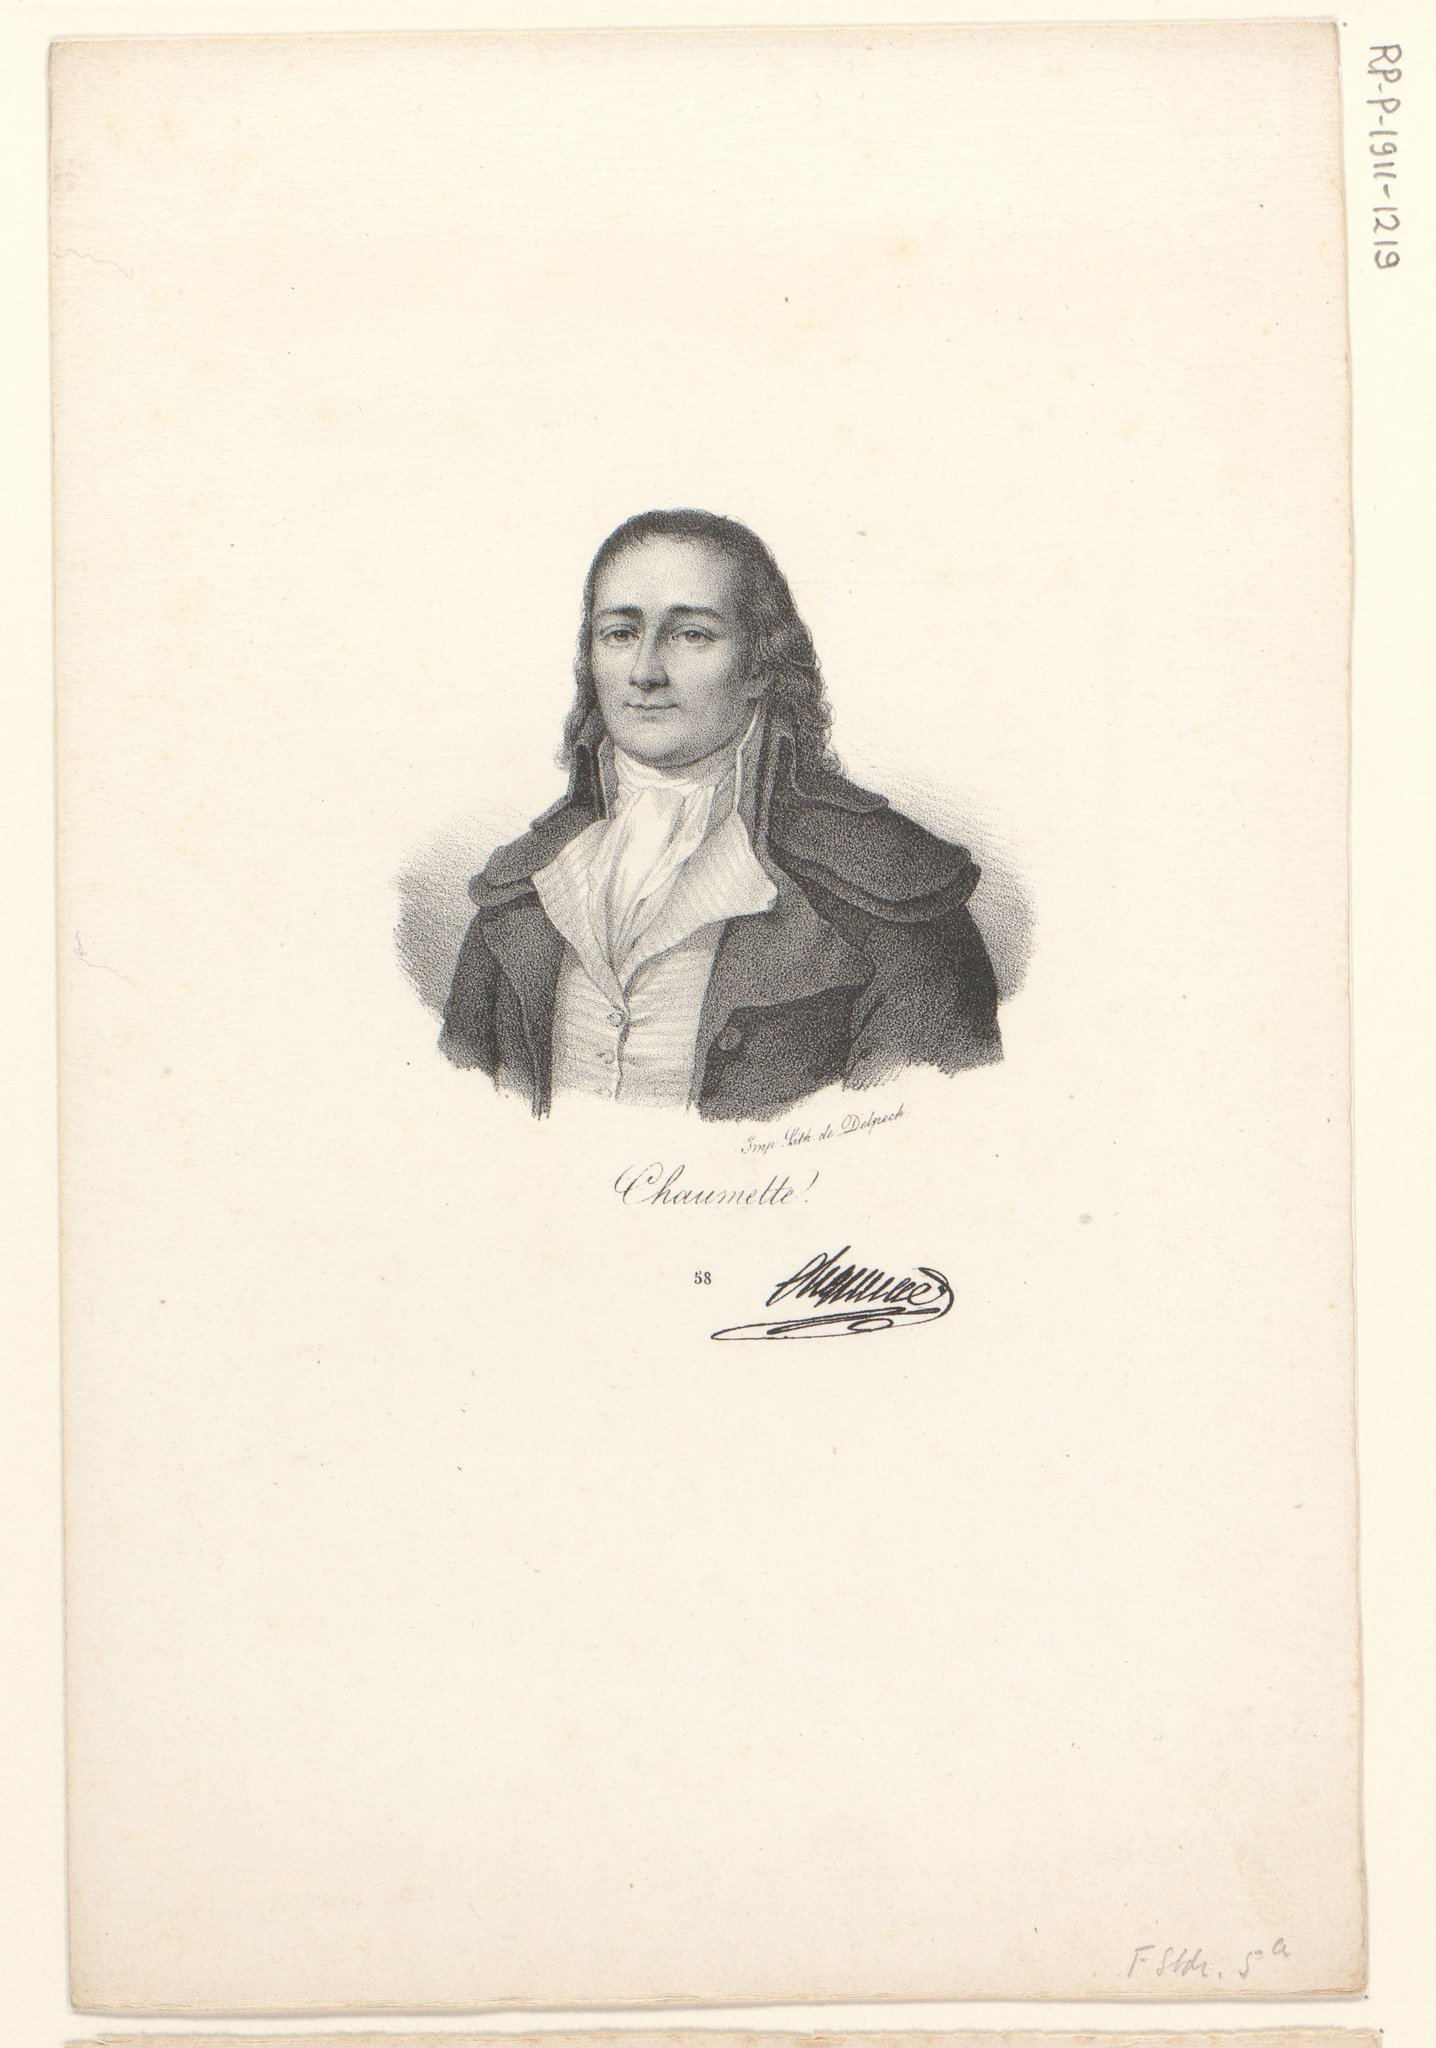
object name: print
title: Chaumette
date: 1818-1842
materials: paper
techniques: lithograph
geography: paris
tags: historical persons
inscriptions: collector's mark: Lugt 2228a